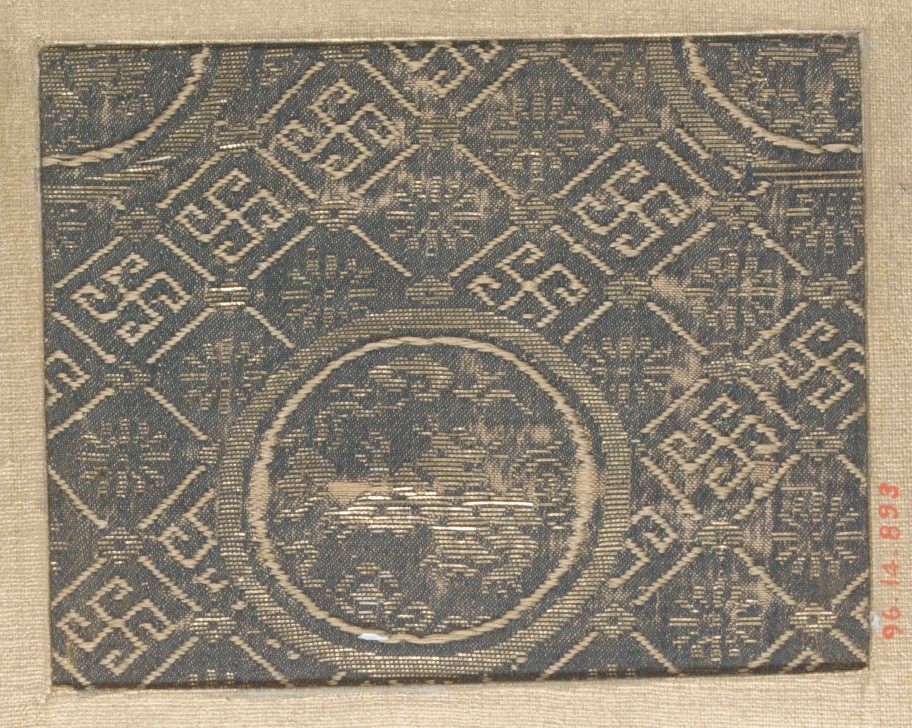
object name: piece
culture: japanese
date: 1701-1900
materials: silk